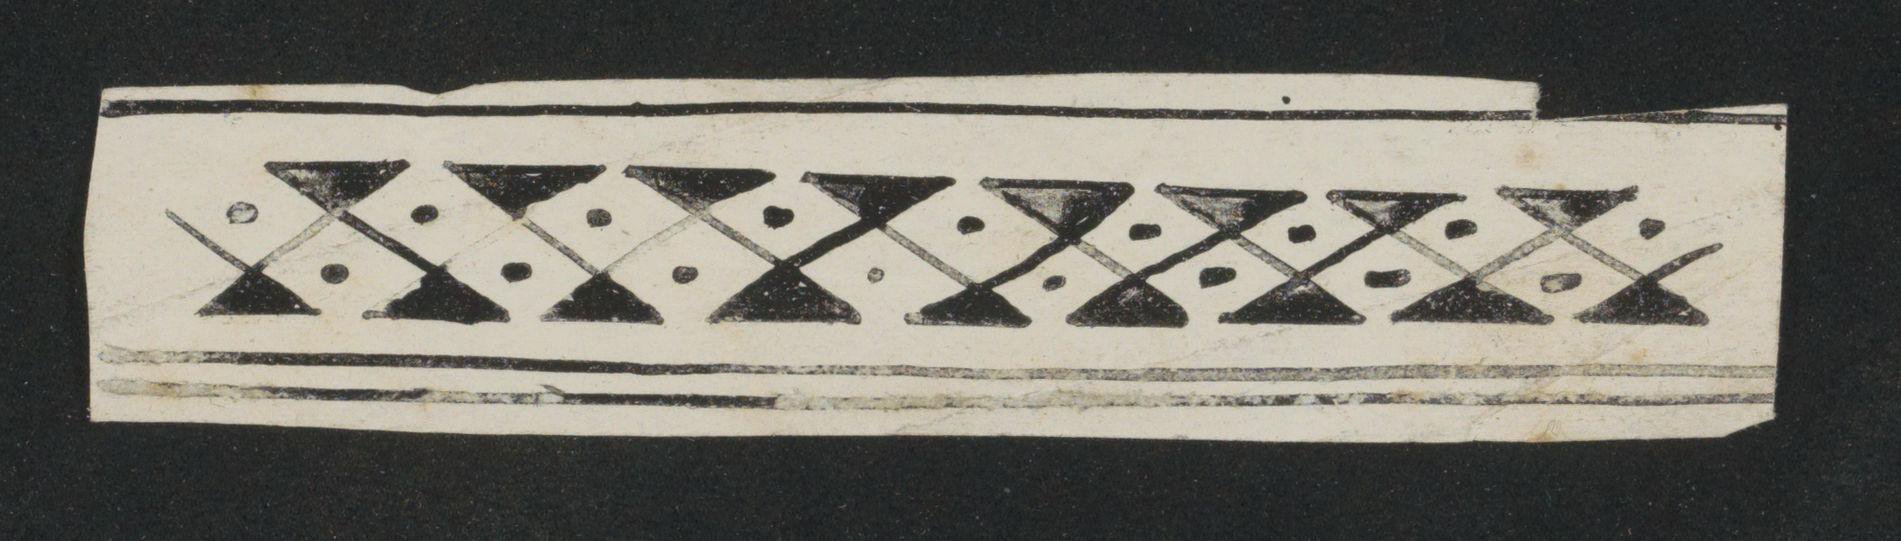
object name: drawing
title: Band met een driehoekmotief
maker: gerrit willem dijsselhof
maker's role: designer, draughtsman, print maker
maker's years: 1866-1924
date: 1876-1924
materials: paper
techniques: lithograph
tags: ornaments ~ art